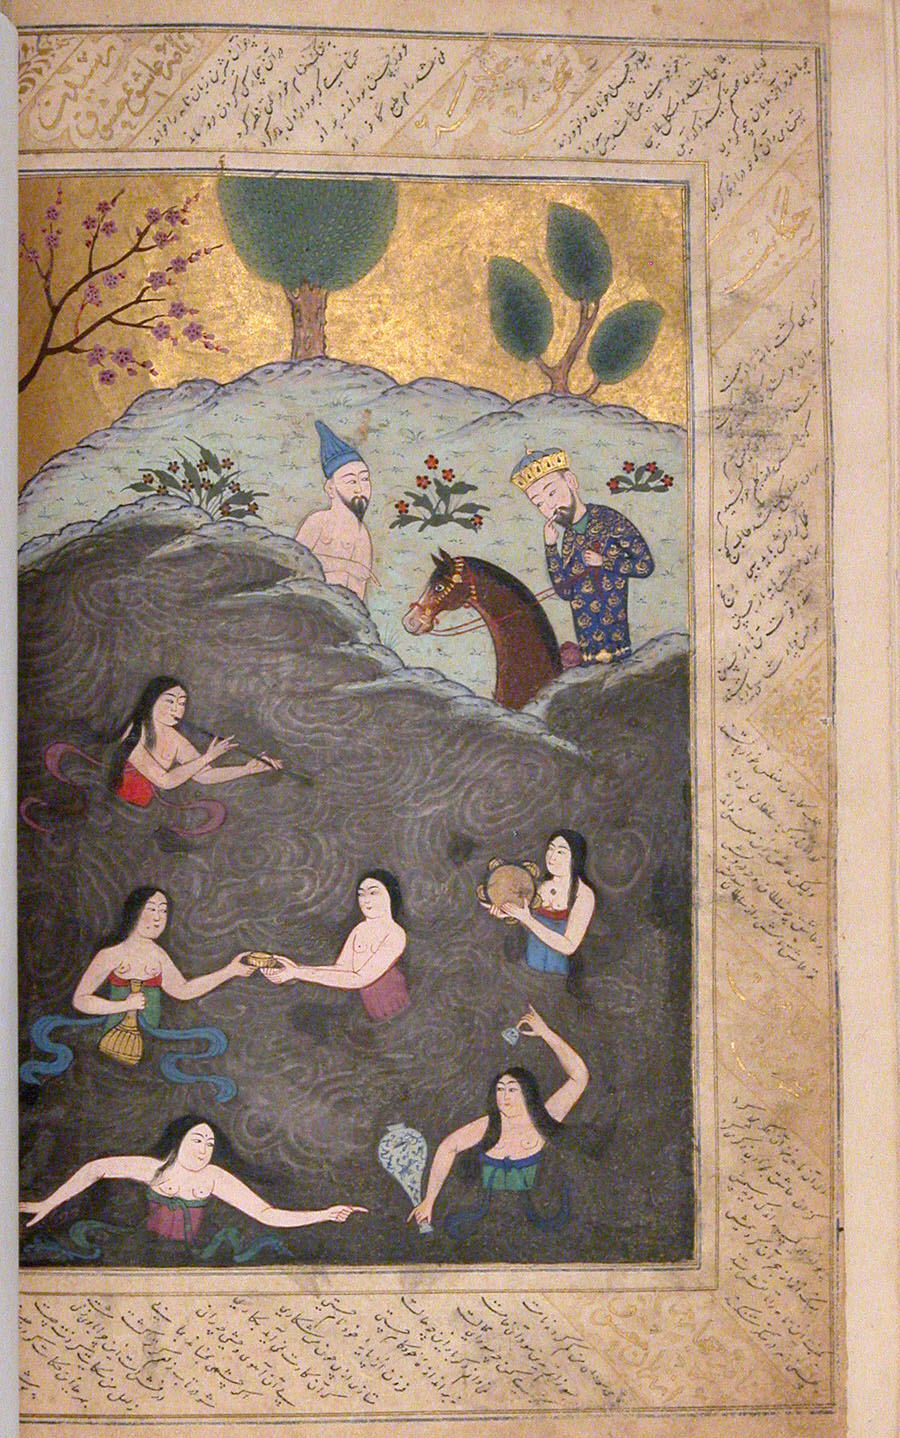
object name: illustrated manuscript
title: Anthology of Persian Poetry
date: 1401-1500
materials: gold, ink, leather, paper, silver, watercolor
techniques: bookbinding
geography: iran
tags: poetry,men,women,horses